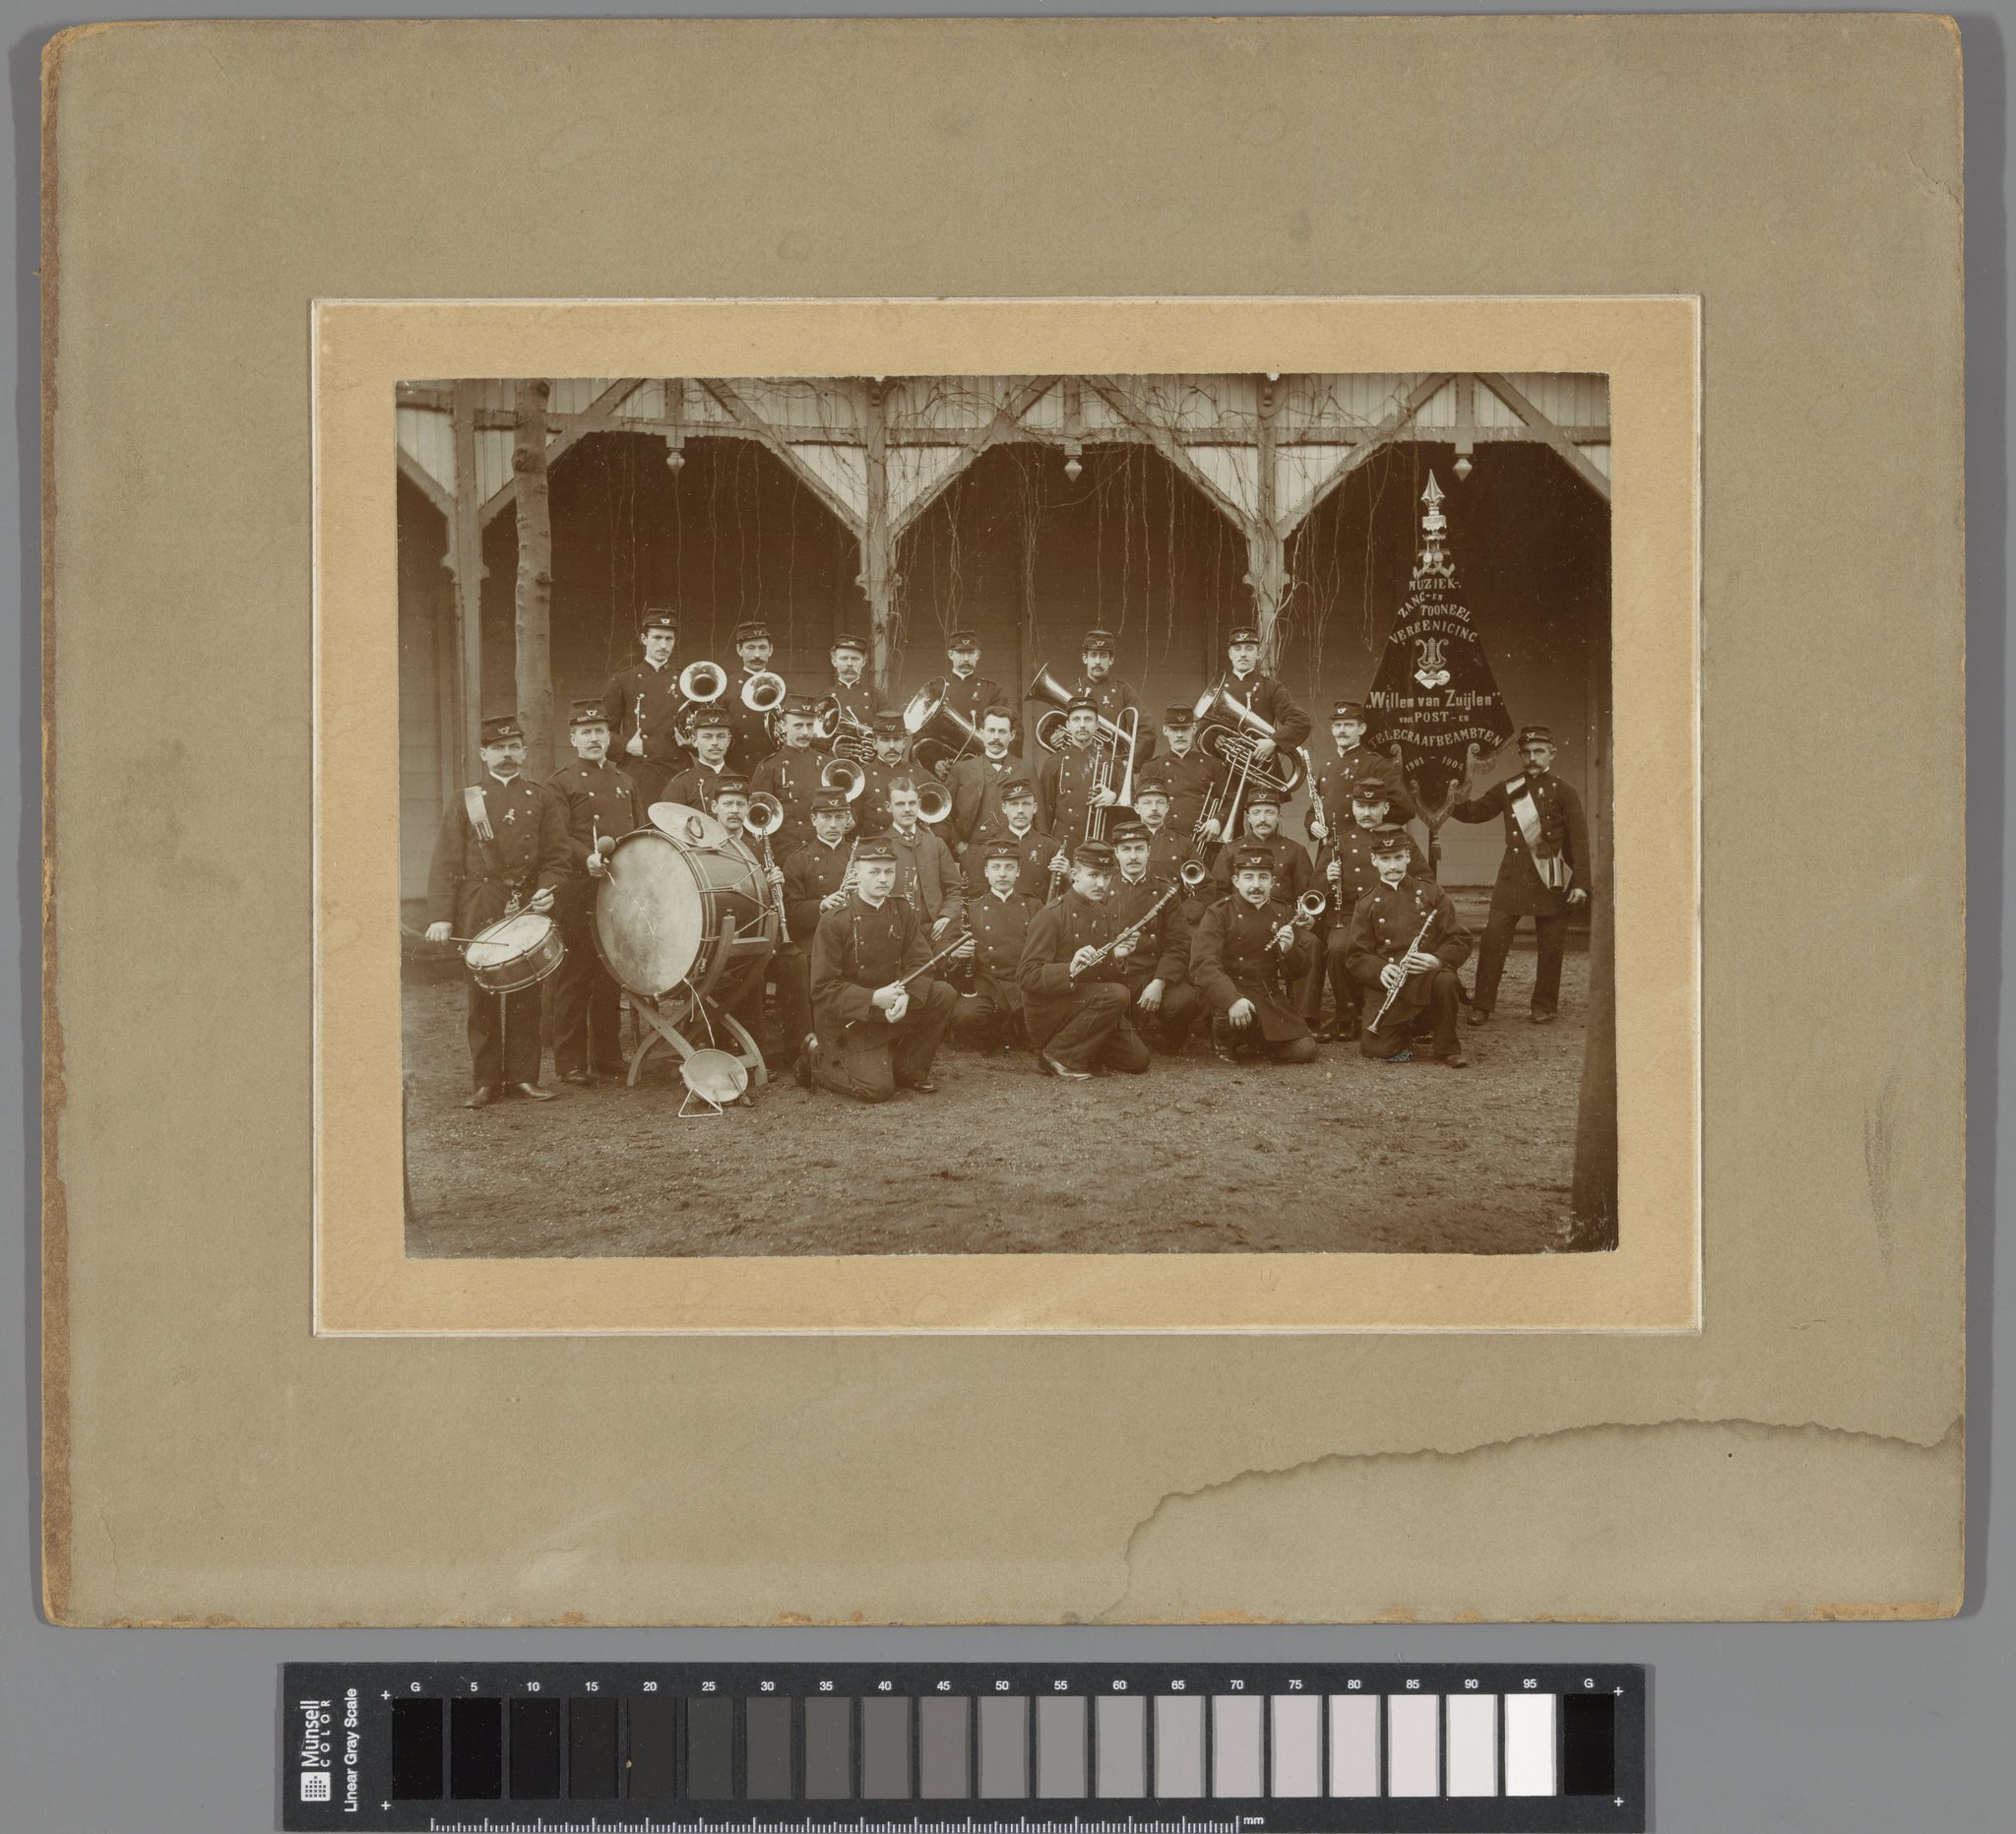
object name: photograph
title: Groepsportret muziek- zang- en toneelvereniging 'Willem van Zuylen' van post-en telegraafbeambten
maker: Anonymous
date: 1904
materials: cardboard, photographic support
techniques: gelatin silver print